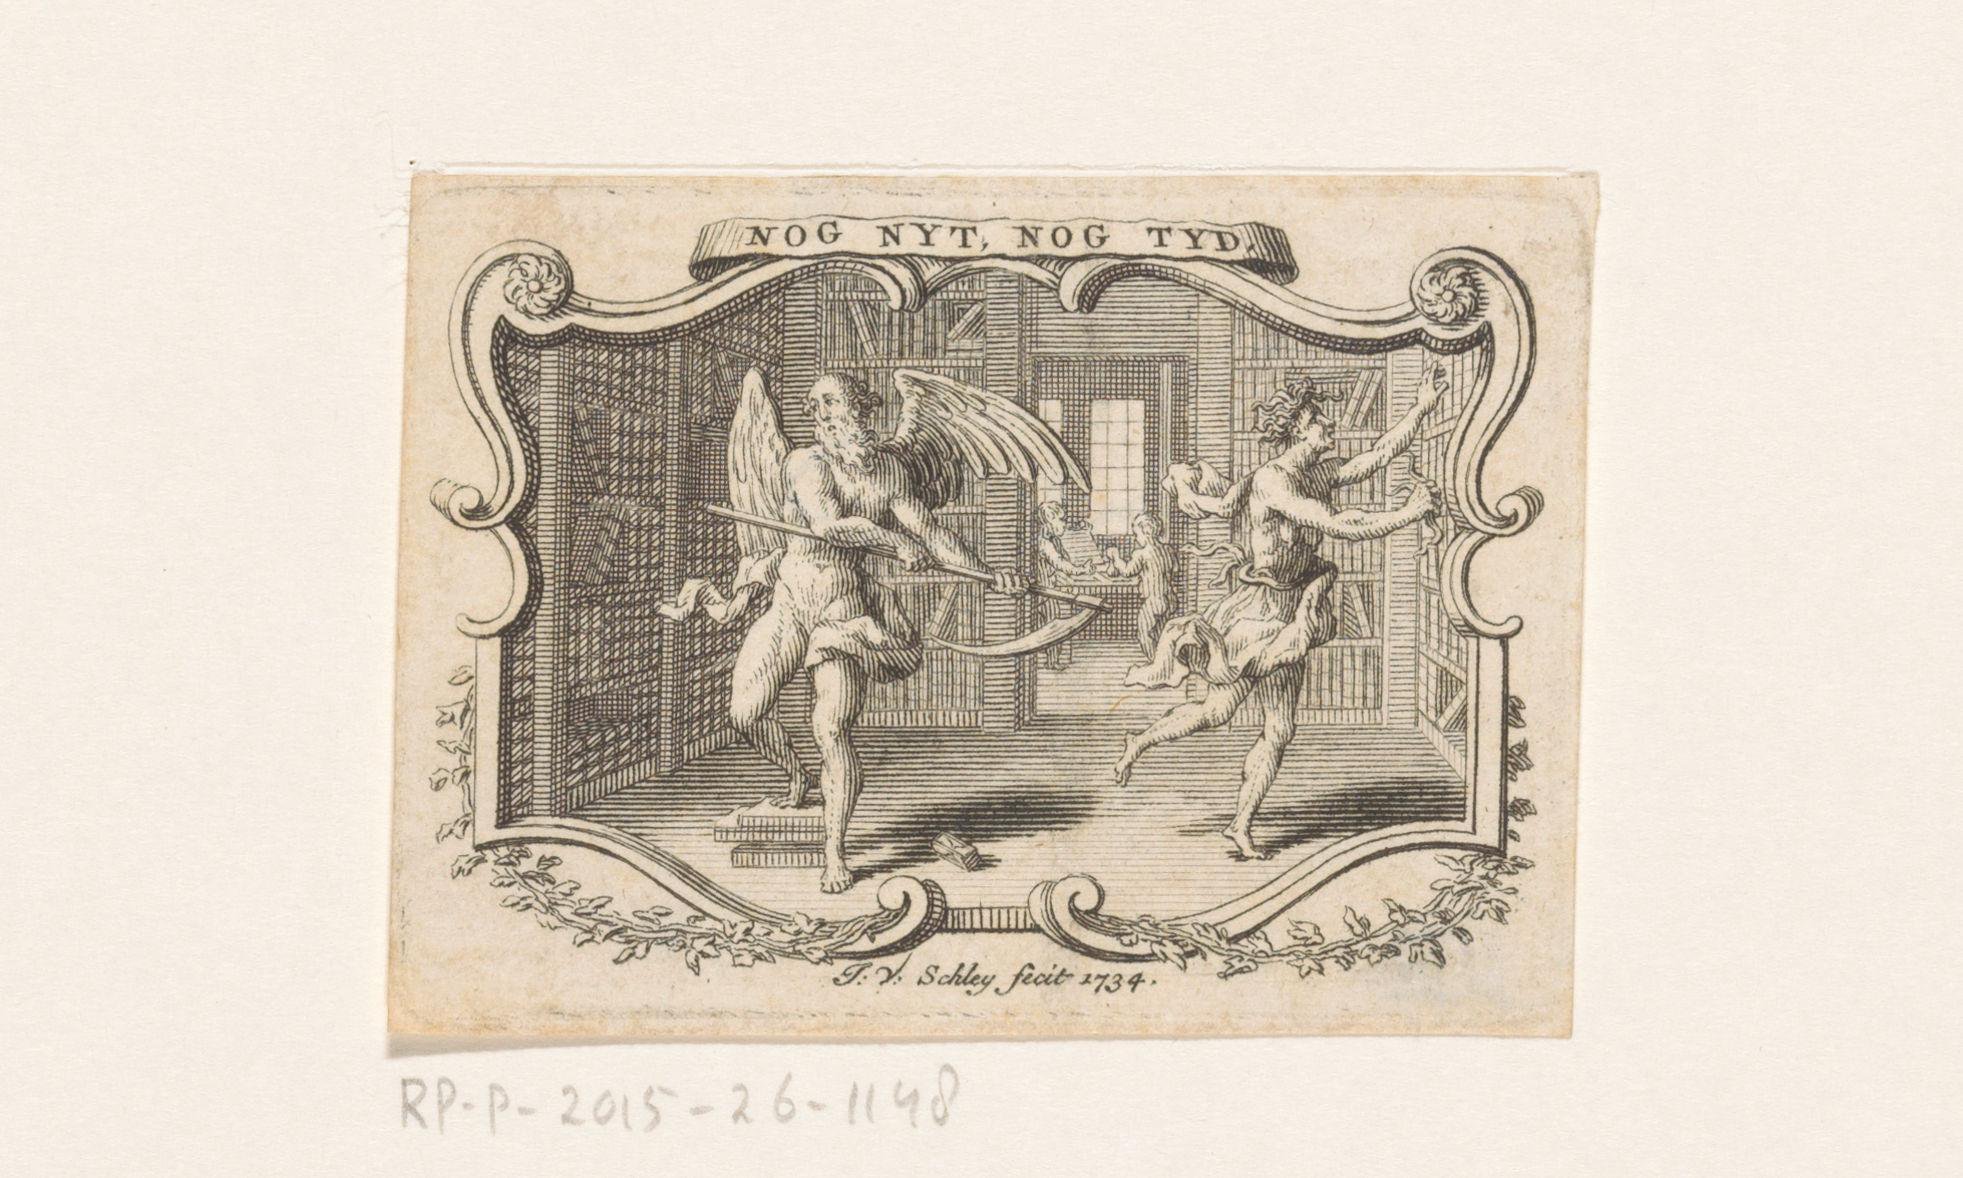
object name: vignette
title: Nog nyt, nog tyd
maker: jacob van der schley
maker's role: draughtsman, print maker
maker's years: 1715-1779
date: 1734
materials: paper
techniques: etching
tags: anger; 'ira' (ripa) ~ personification of one of the seven deadly sins, father time, man with wings and scythe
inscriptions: : Lugt 4780, collector's mark: Lugt 2228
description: In de achtergrond een doorkijk naar een ruimte met twee putti die een zetsel ininkten.